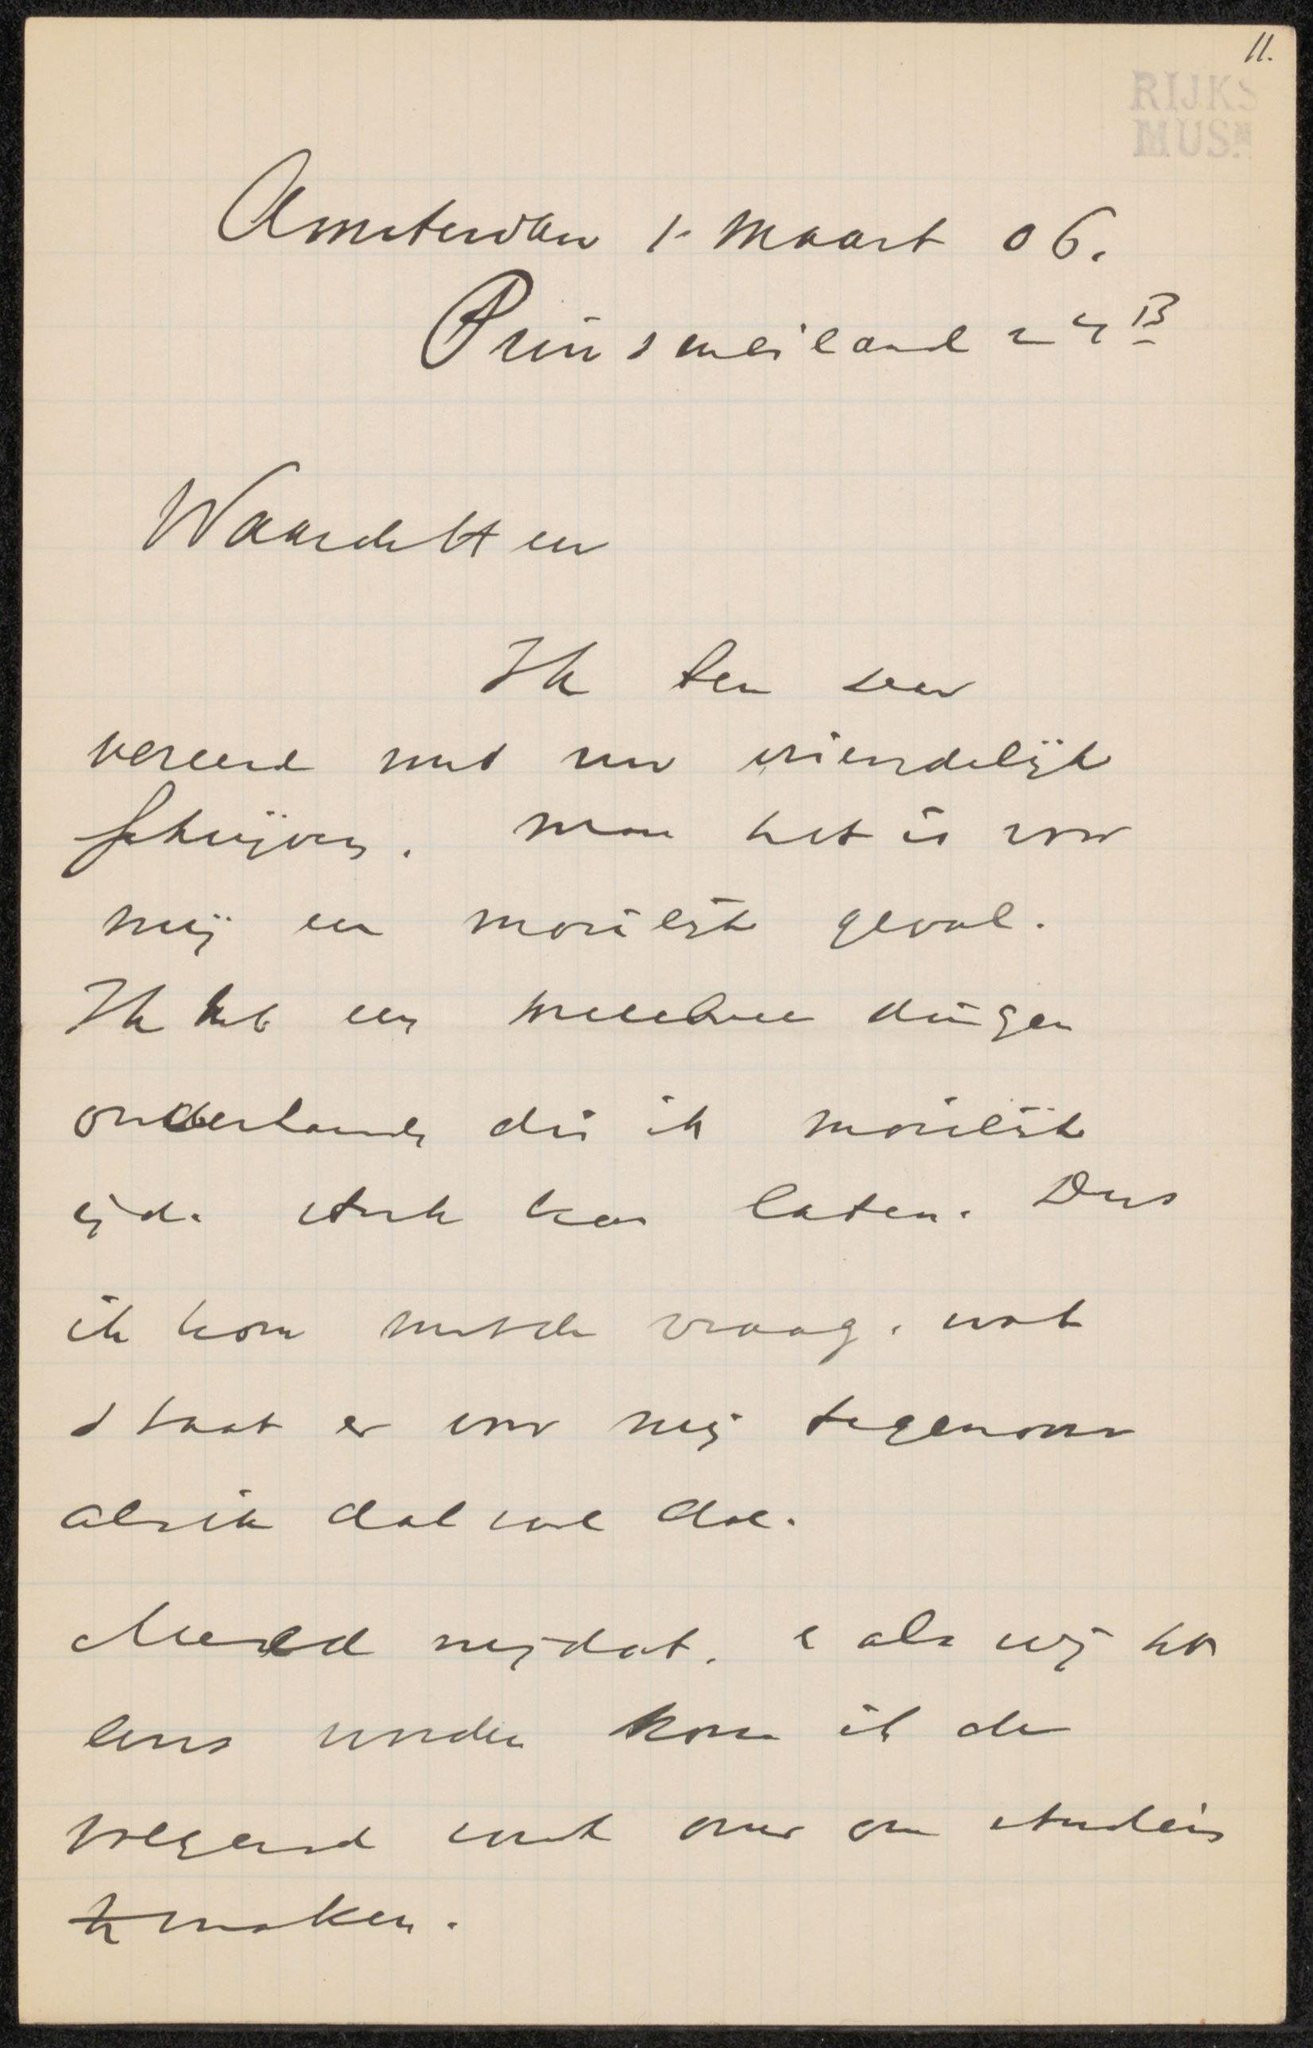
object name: letter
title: Brief aan Pieter Haverkorn van Rijsewijk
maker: george hendrik breitner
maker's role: draughtsman, painter, print maker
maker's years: 1857-1923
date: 1906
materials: ink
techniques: pen, writing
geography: amsterdam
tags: pieter haverkorn van rijsewijk, painting (including book-illumination, miniature-painting), amsterdam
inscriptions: collector's mark: Lugt 2166